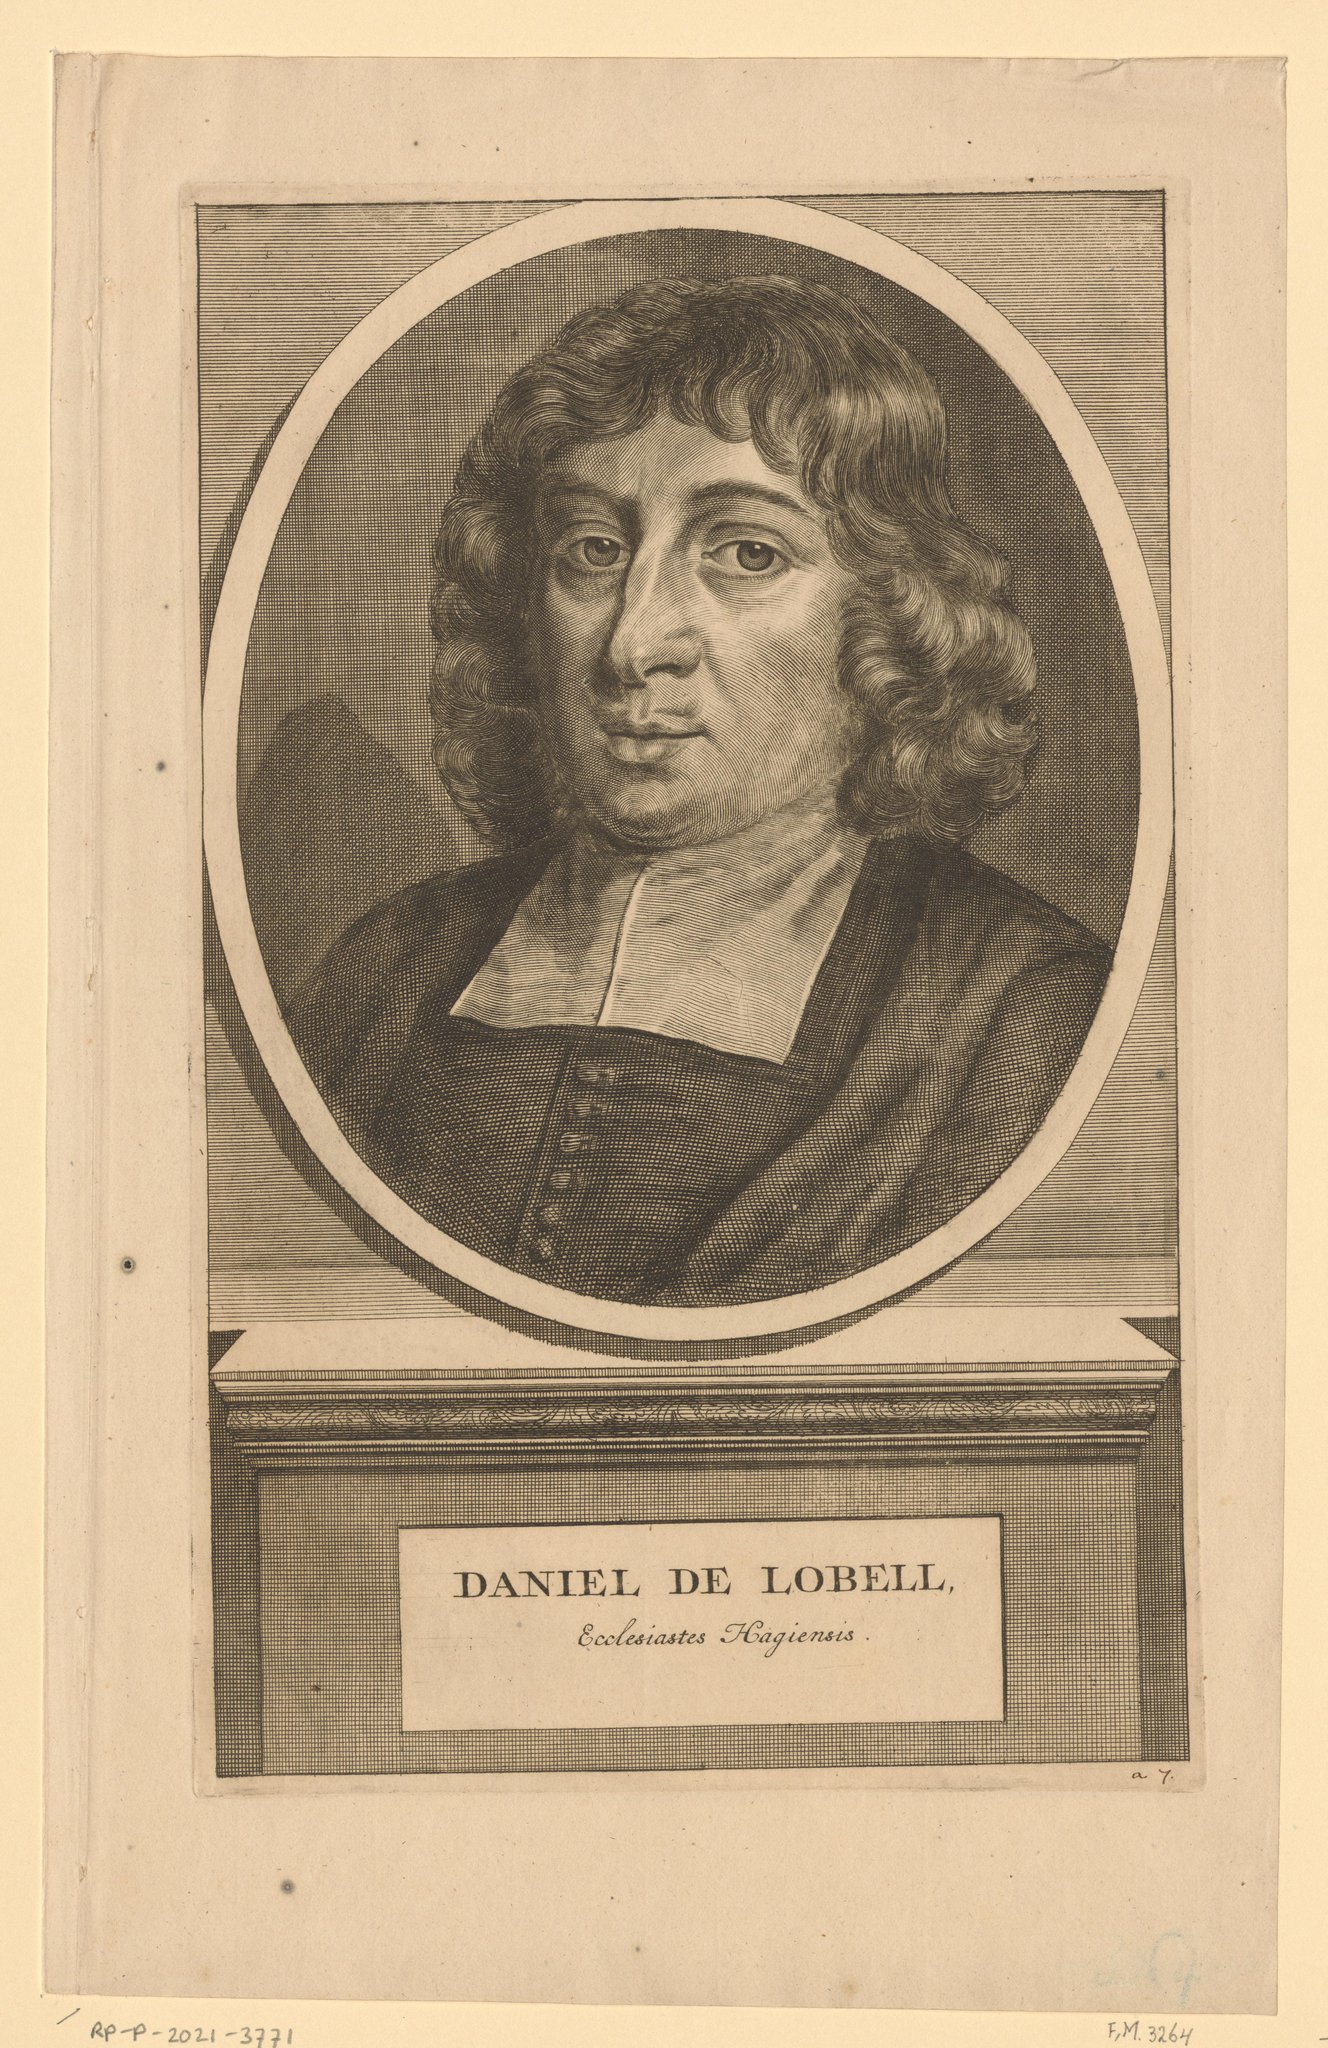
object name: print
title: Portret van Daniel de Lobell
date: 1687-1691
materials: paper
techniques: engraving, etching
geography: leiden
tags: historical persons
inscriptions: number: ‘a 7.’